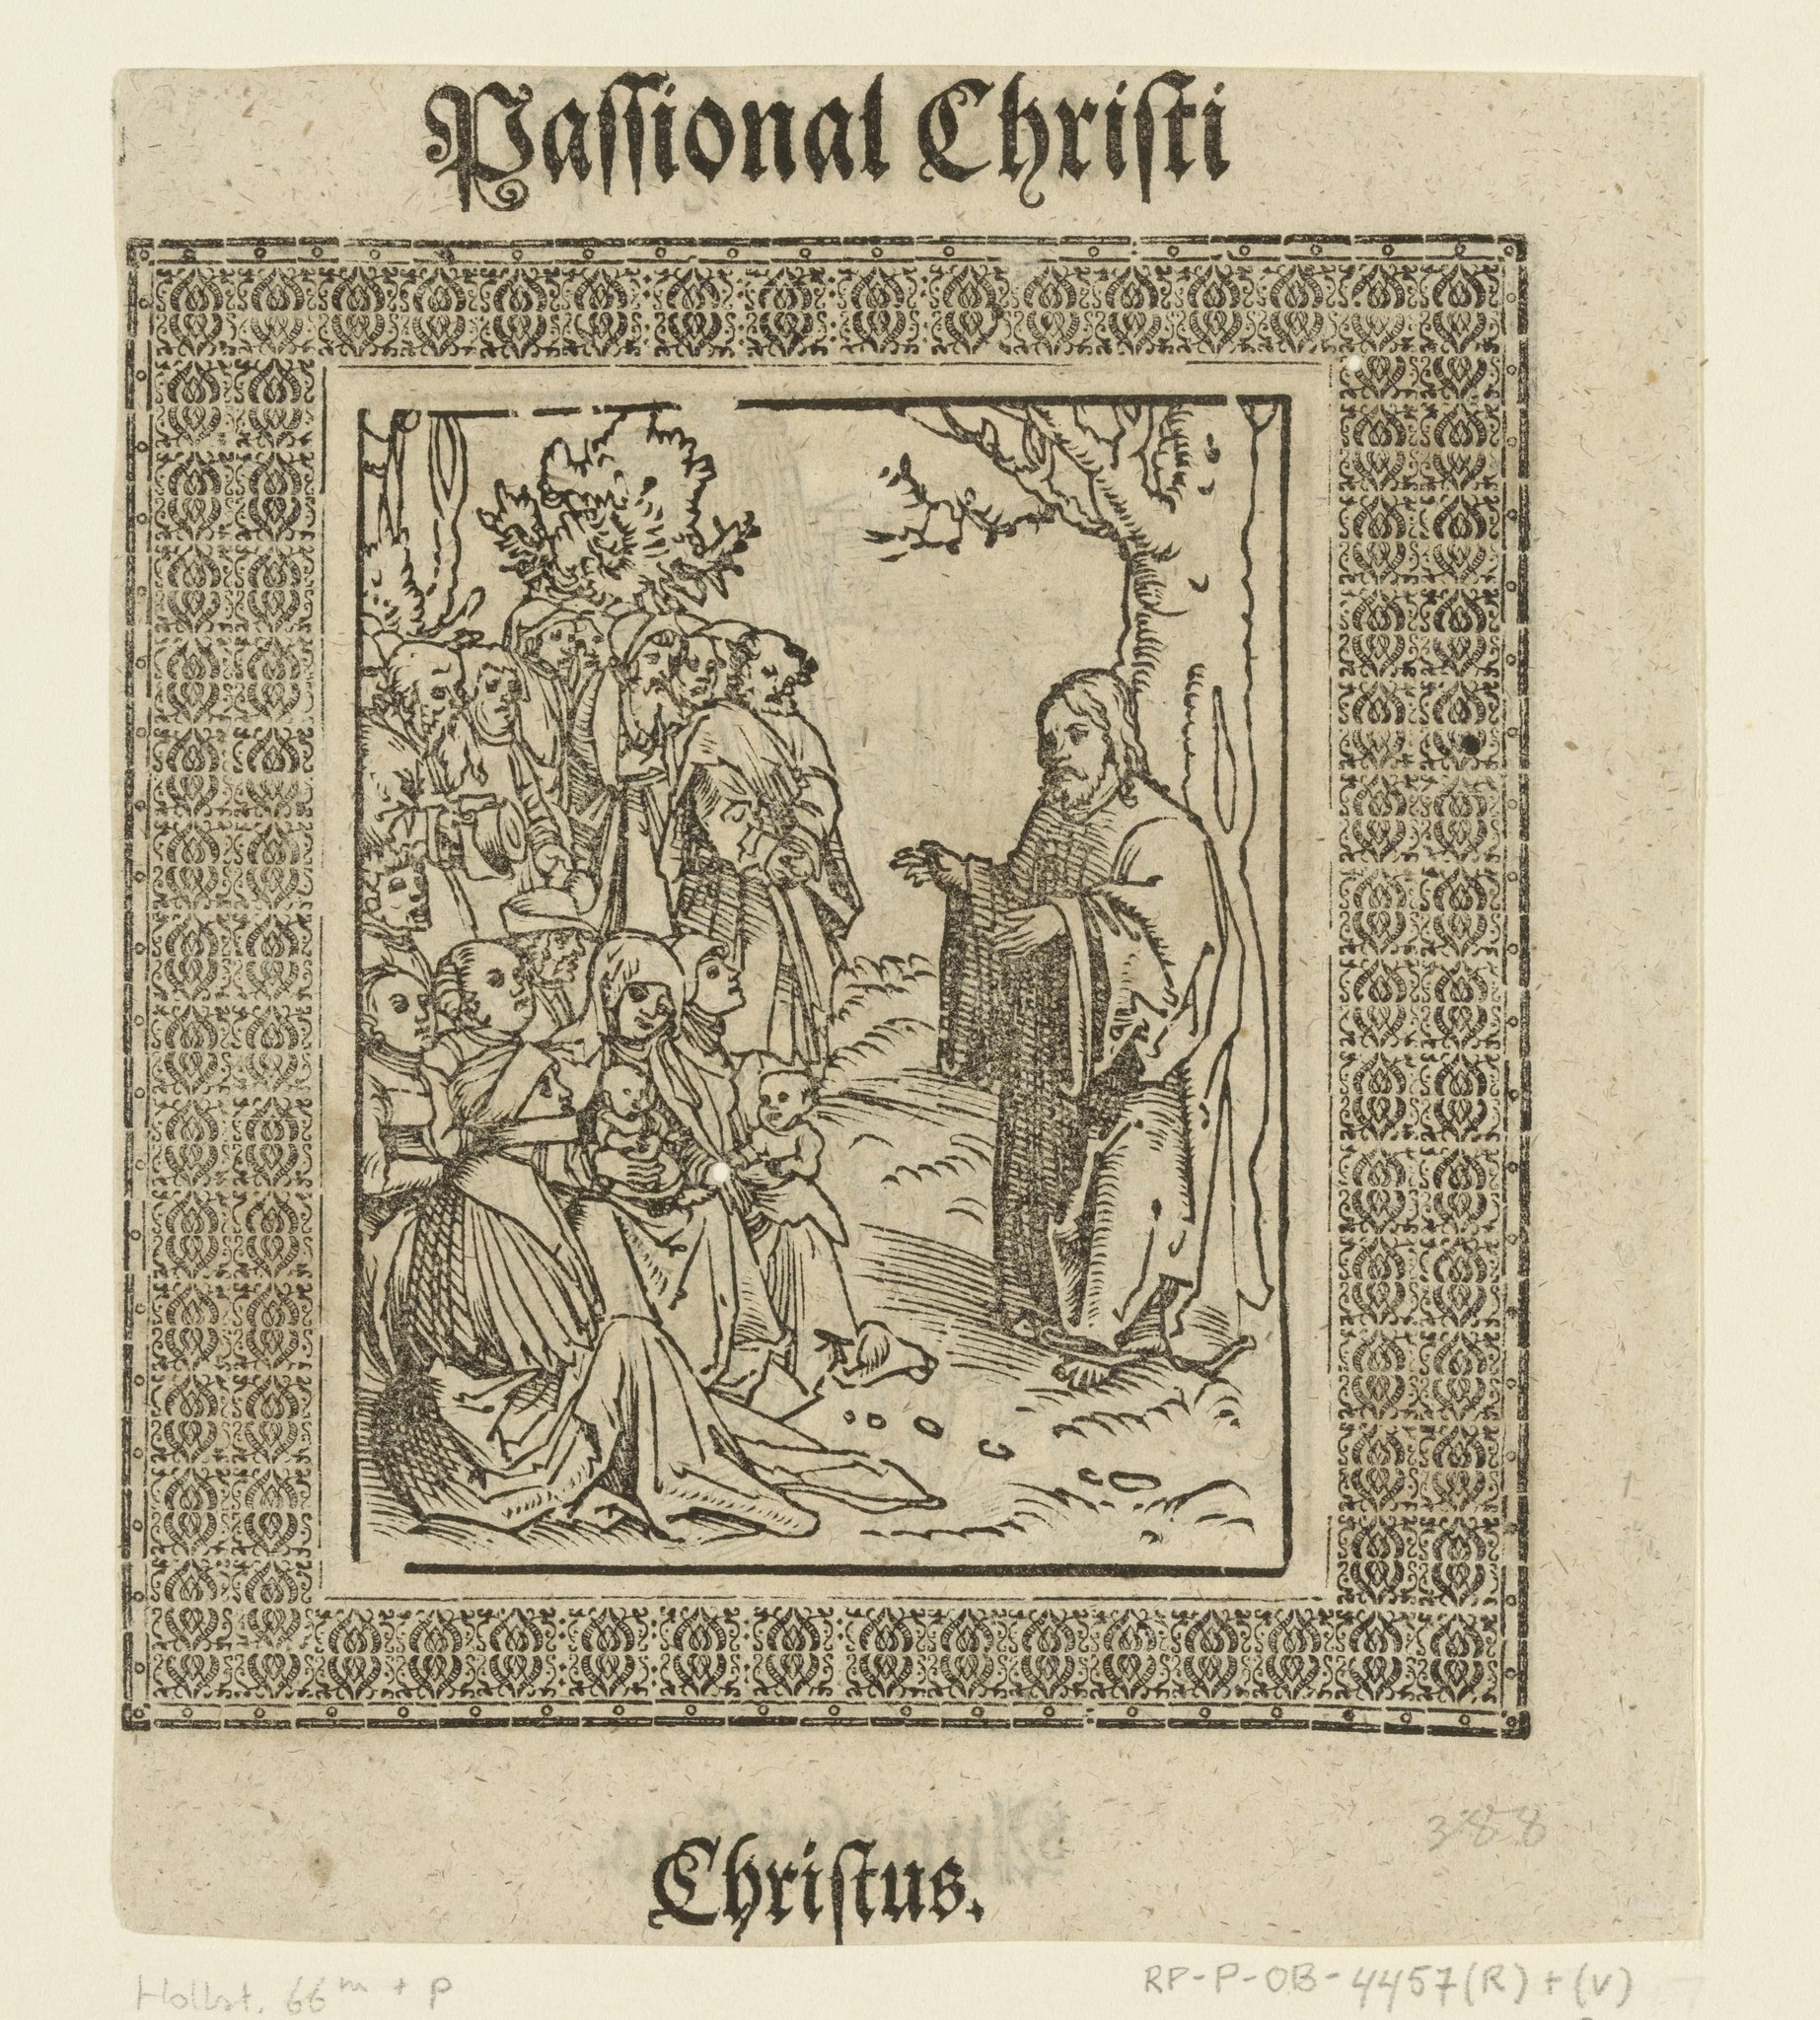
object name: print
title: Christus predikt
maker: lucas cranach (i)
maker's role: draughtsman, print maker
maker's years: 1472-1553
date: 1521-1522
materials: paper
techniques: woodcut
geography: wittenberg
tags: christ preaching or teaching (in general)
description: De tegenhanger van deze prent is de voorstelling Paus en geestelijken aan een feestmaal, zie RP-P-OB-4459(V). Blad uit: Passional Christi und Antichristi, Wittenberg 1521-1522, Johann Grünenberg. In 1521-1522 verschenen veel verschillende uitgaven van dit populaire werk van Maarten Luther. In de collectie van het RMA bevindt zich de complete serie van zesentwintig afbeeldingen uit een van deze uitgaven. De pagina's zijn op een kleiner formaat gesneden, onder iedere voorstelling stond oorspronkelijk een aantal regels Duitse tekst. De bladen hebben allemaal op dezelfde plaats twee kleine gaatjes van vraat door ongedierte wat er op wijst dat ze behoren tot hetzelfde exemplaar.